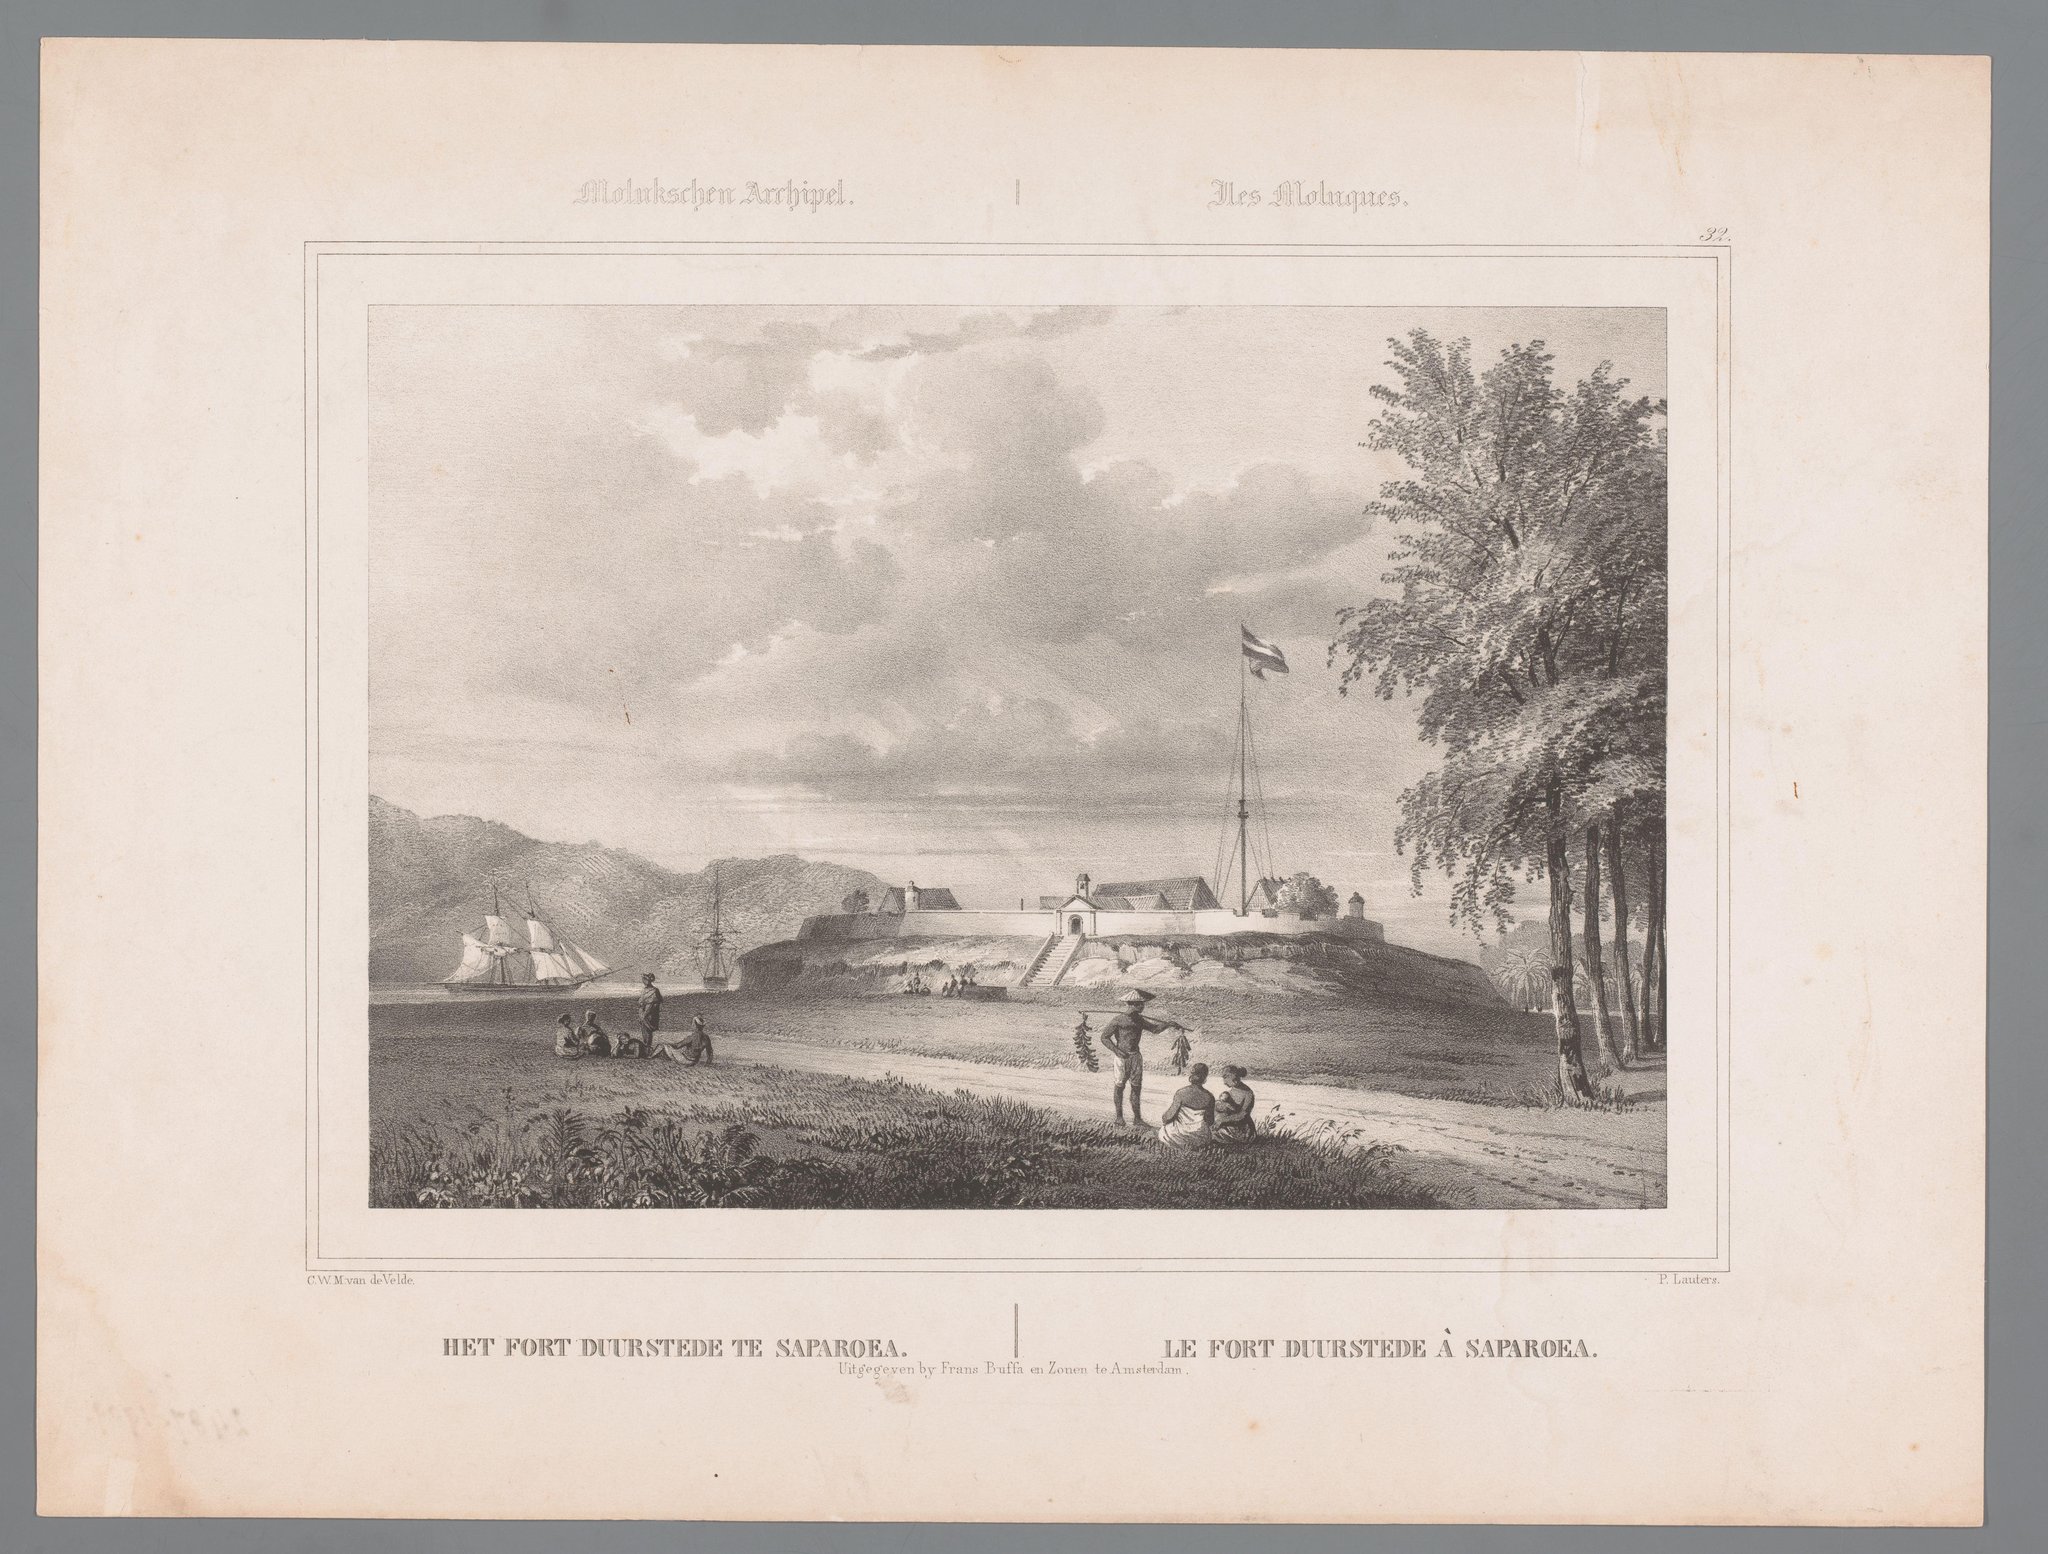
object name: print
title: Molukschen archipel / Iles Moluques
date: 1847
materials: paper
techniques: lithograph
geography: amsterdam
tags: fortress, flagpole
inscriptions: stamp: ‘Koloniaal Museum Haarlem’, collector's mark: Lugt 2228, inscription: ‘26; 2487-1909’, label: ‘Koloniaal Instituut - Amsterdam; No. 15650; Doos No. 157A; Onderwerp: Het fort Duurstede te Saparoea. Afkomst: kol. mus. Haarlem.’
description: Andere staat behoort tot de serie: Gezigten uit Neerlands Indië. Amsterdam: Frans Buffa en Zonen, [1847].